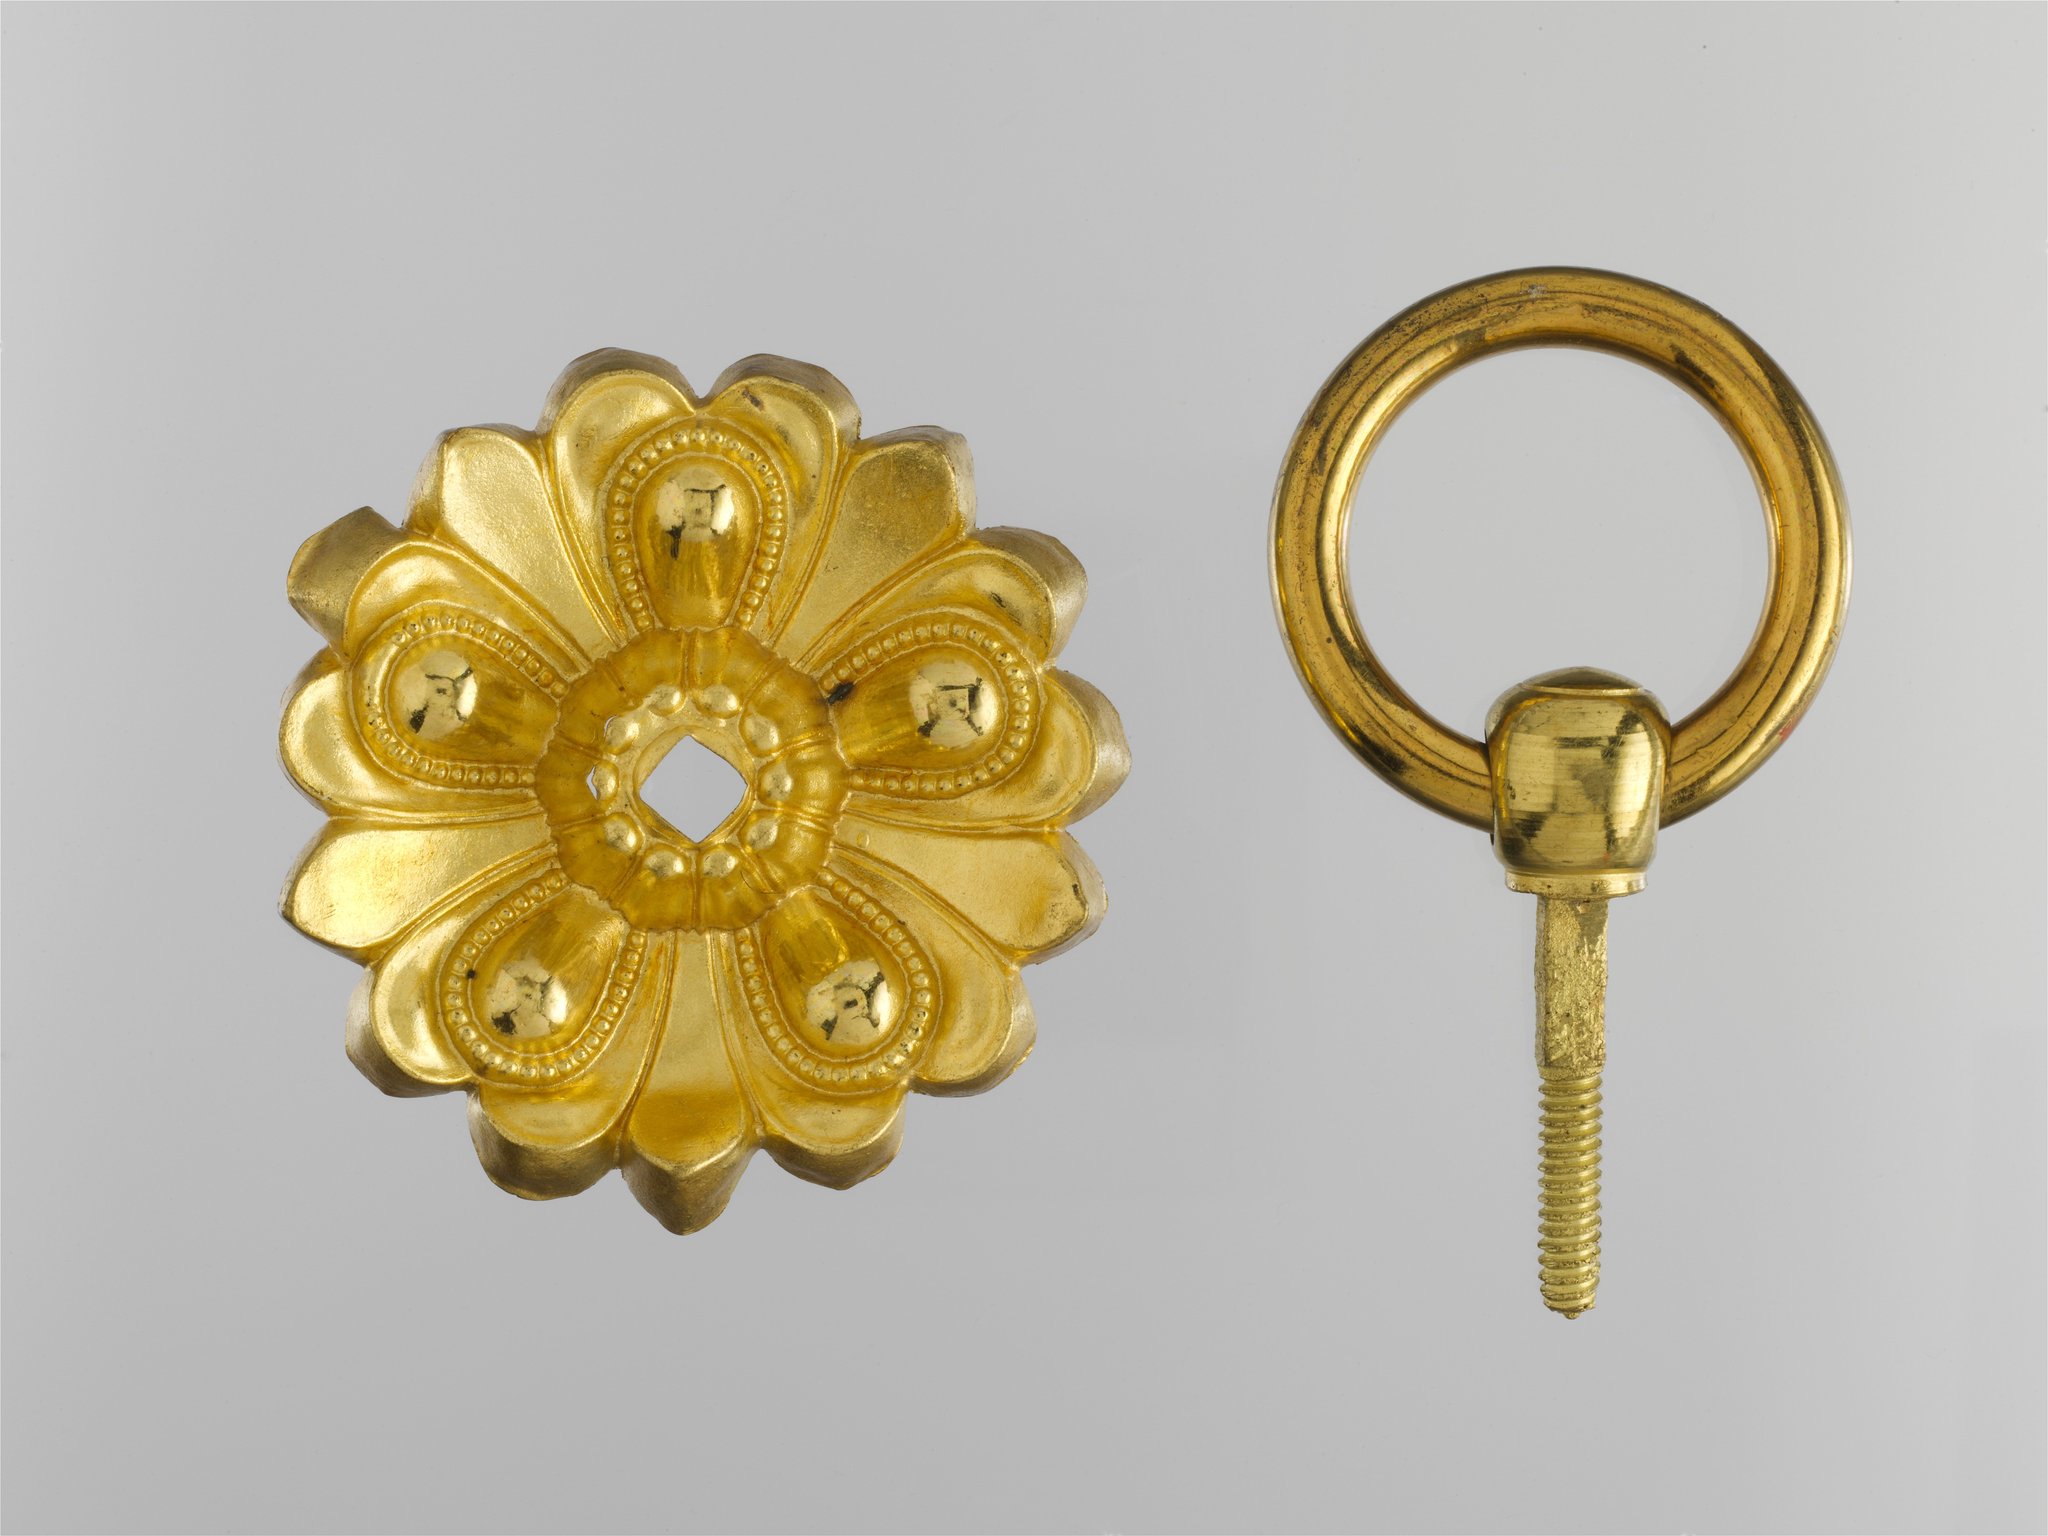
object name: furniture hardware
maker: henry kellam hancock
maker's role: retailer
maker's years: 1816-1851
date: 1820-1830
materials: brass, gilt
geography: france